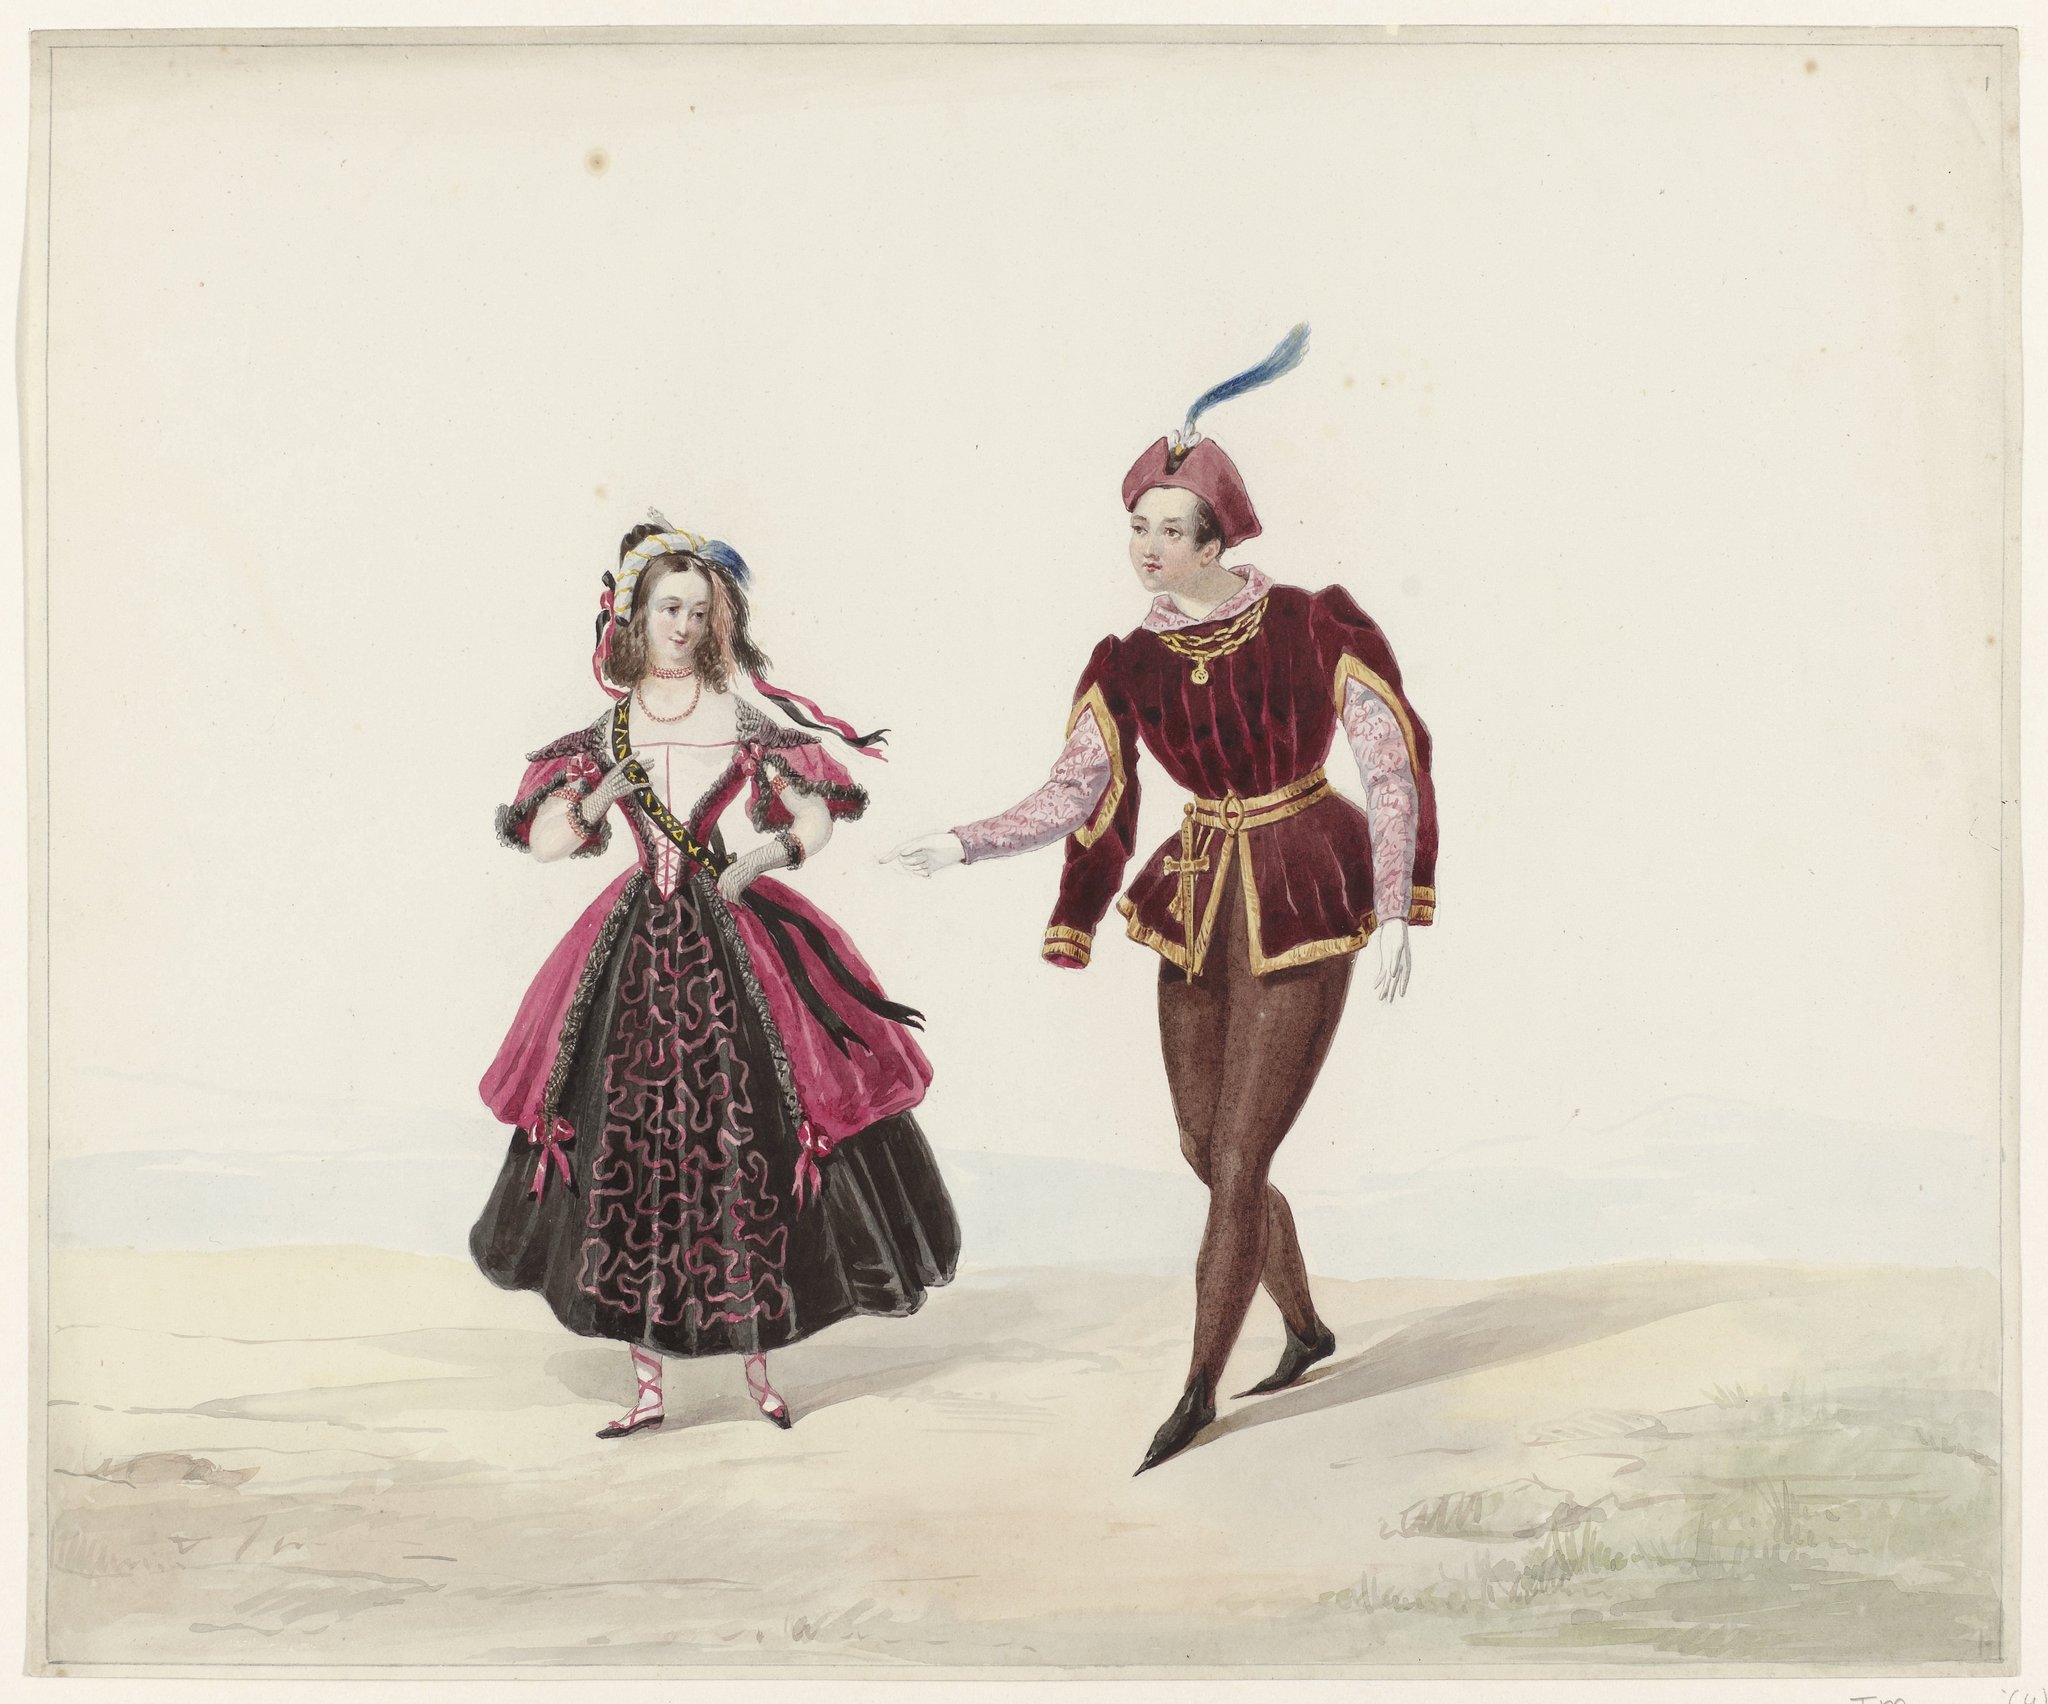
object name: costume print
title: Man en vrouw in historisch kostuum, 1841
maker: huib van hove bz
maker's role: painter, print maker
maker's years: 1814-1867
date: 1841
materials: paper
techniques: drawing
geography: netherlands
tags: the hague, anna paulowna romanowa, william ii of the netherlands, historical costume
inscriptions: collector's mark: Lugt 2228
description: Man en vrouw in historisch kostuum. Mogelijk Poolse kledingdracht. Kostuums gedragen op het gekostumeerde bal gehouden te Den Haag op 17 en 19 februari 1841 bij het 25-jarig huwelijk van koning Willem II en Anna Paulowna. Platen naar sommige van deze voorstellingen komen voor in een album over dit bal.